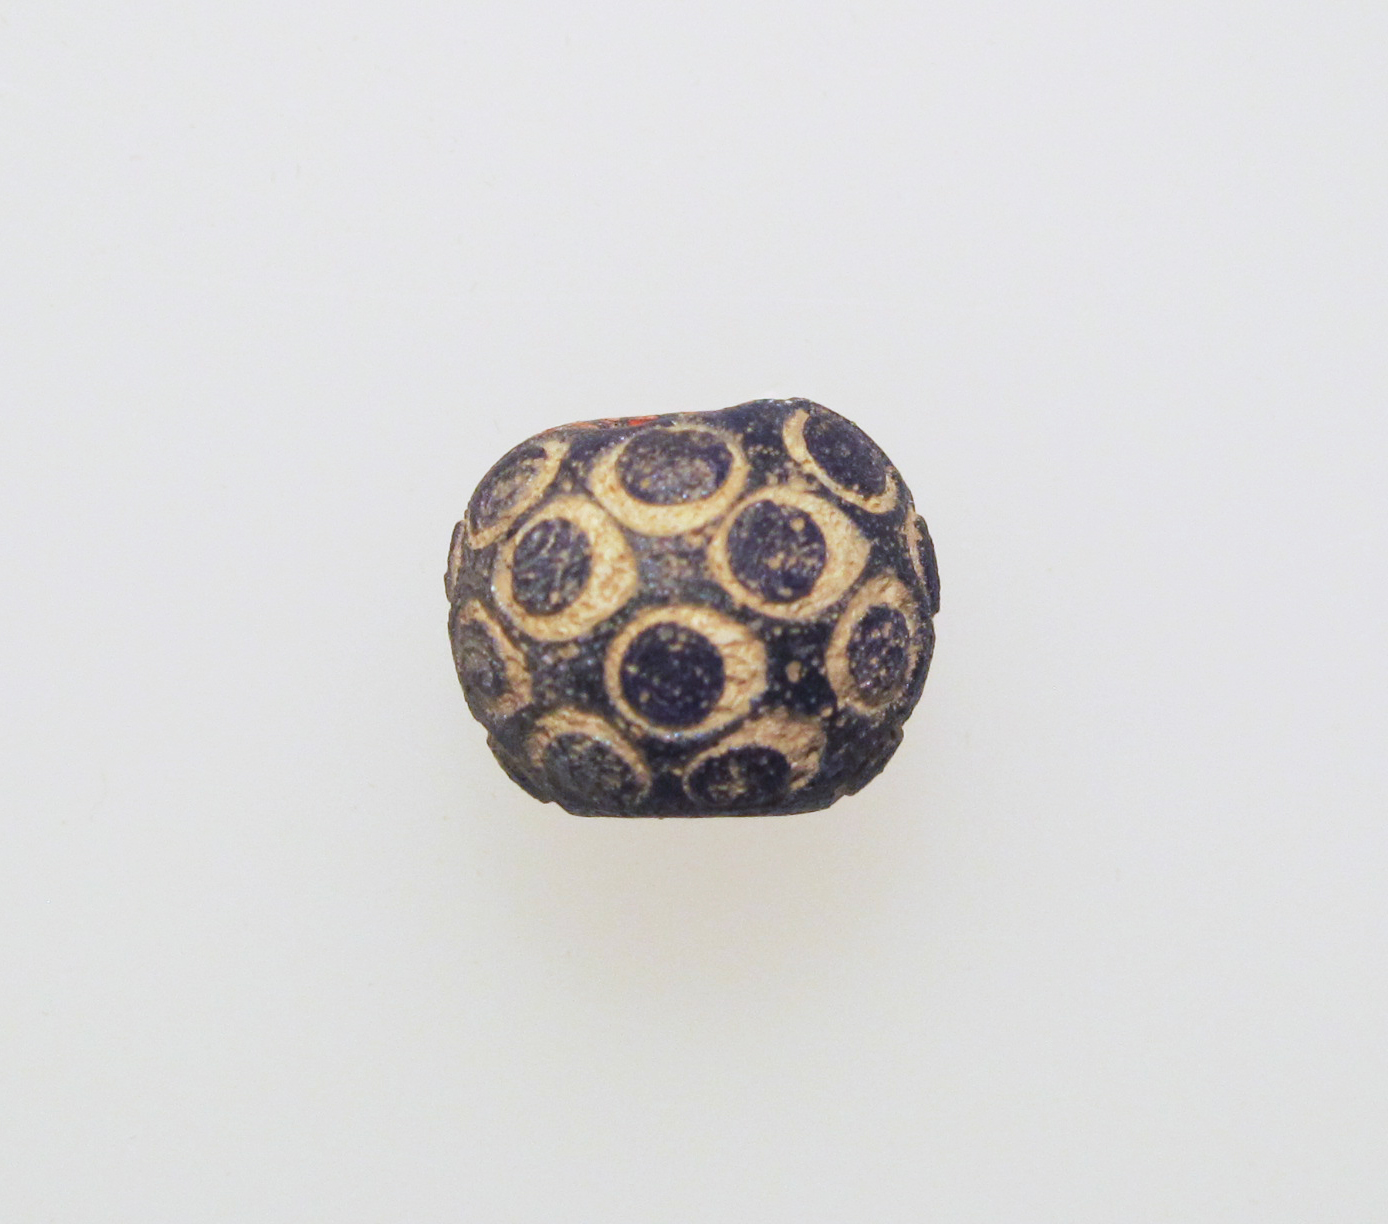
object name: bead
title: Glass eye bead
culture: greek, eastern mediterranean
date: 400-301 BCE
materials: glass